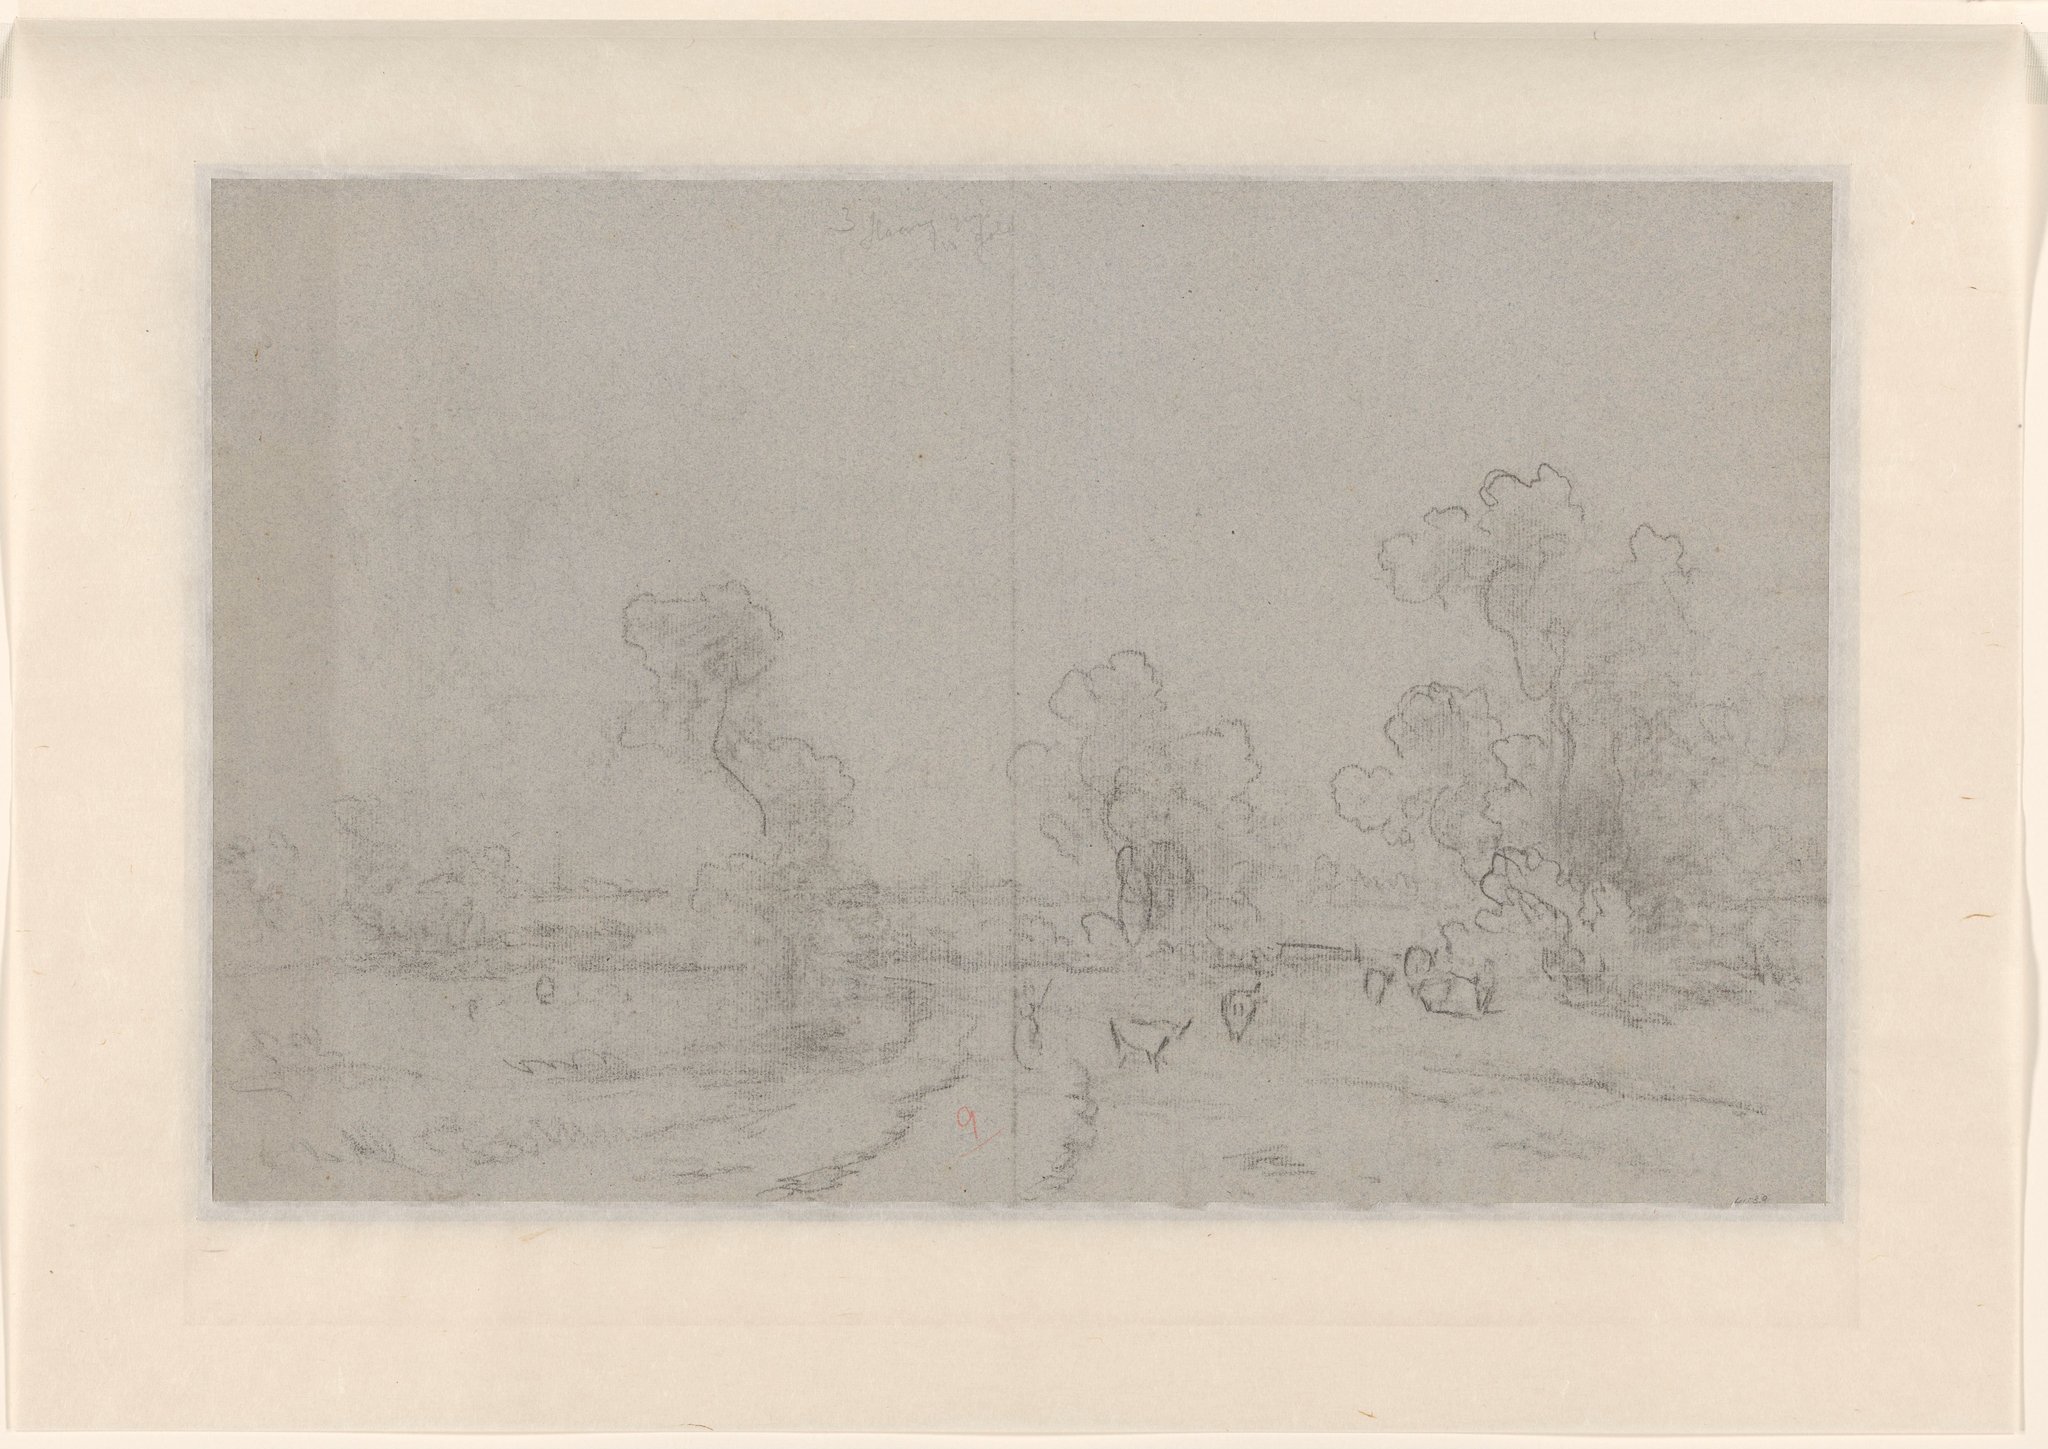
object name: drawing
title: Schets van een landschap met enkele beesten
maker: piet meiners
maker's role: draughtsman, painter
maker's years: 1857-1903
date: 1867-1903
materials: chalk, paper